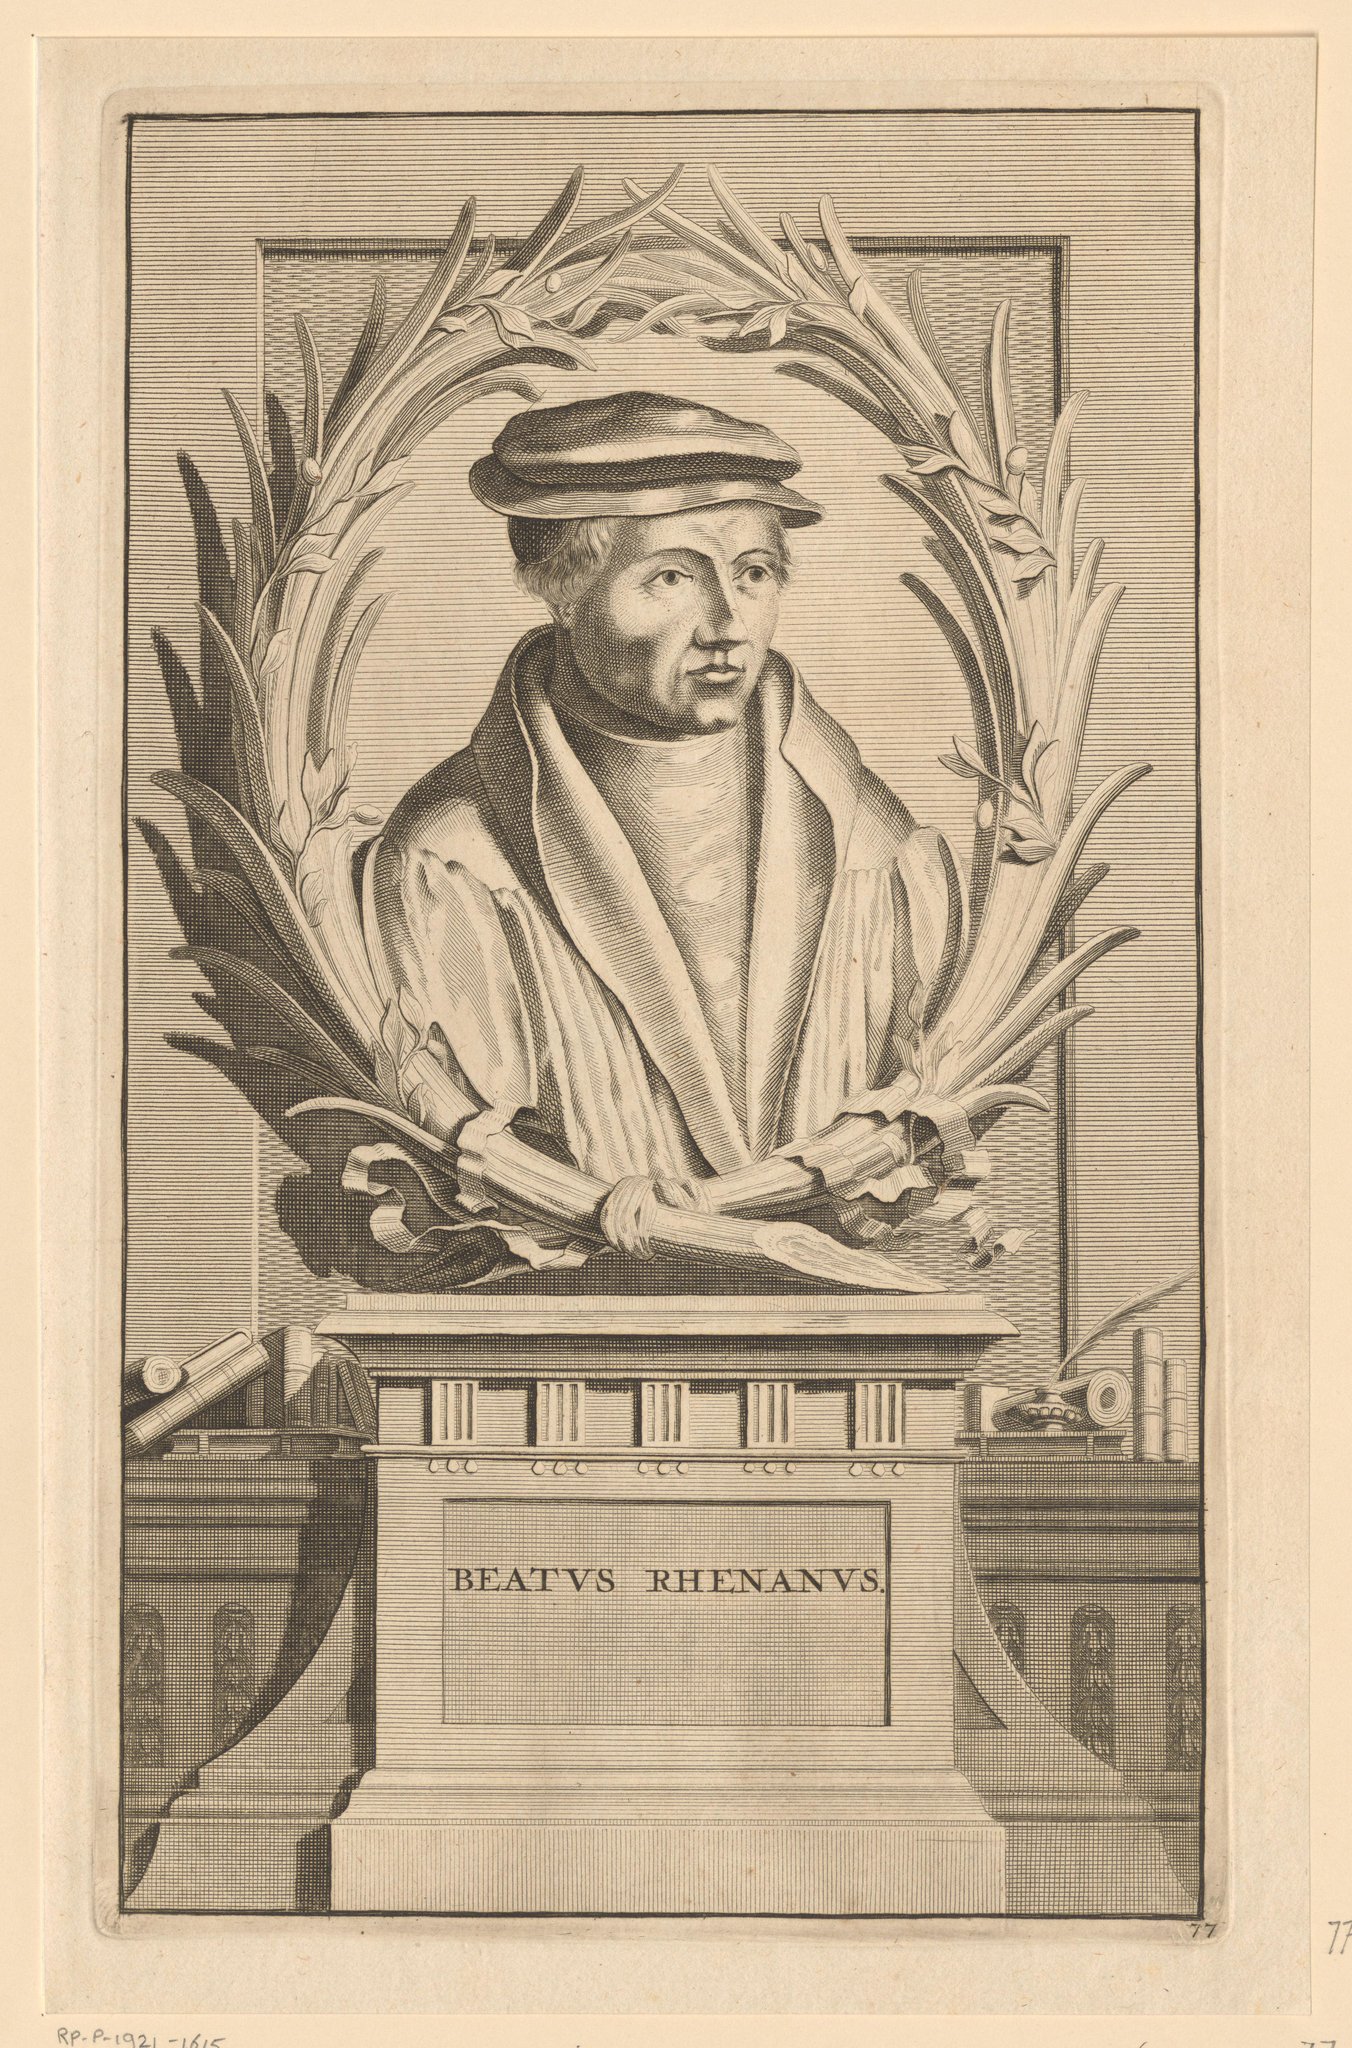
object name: book illustration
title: Portret van Beatus Rhenanus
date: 1675-1733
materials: paper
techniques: engraving, etching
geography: leiden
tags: historical persons, book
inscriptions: collector's mark: Lugt 2233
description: Prent uit: Principum et illustrium quorundam virorum qui in Europa alibique terrarum qua fama, qua eruditione celebres fuerynt, verae imagines. Leiden: Pieter van der Aa, s.a.